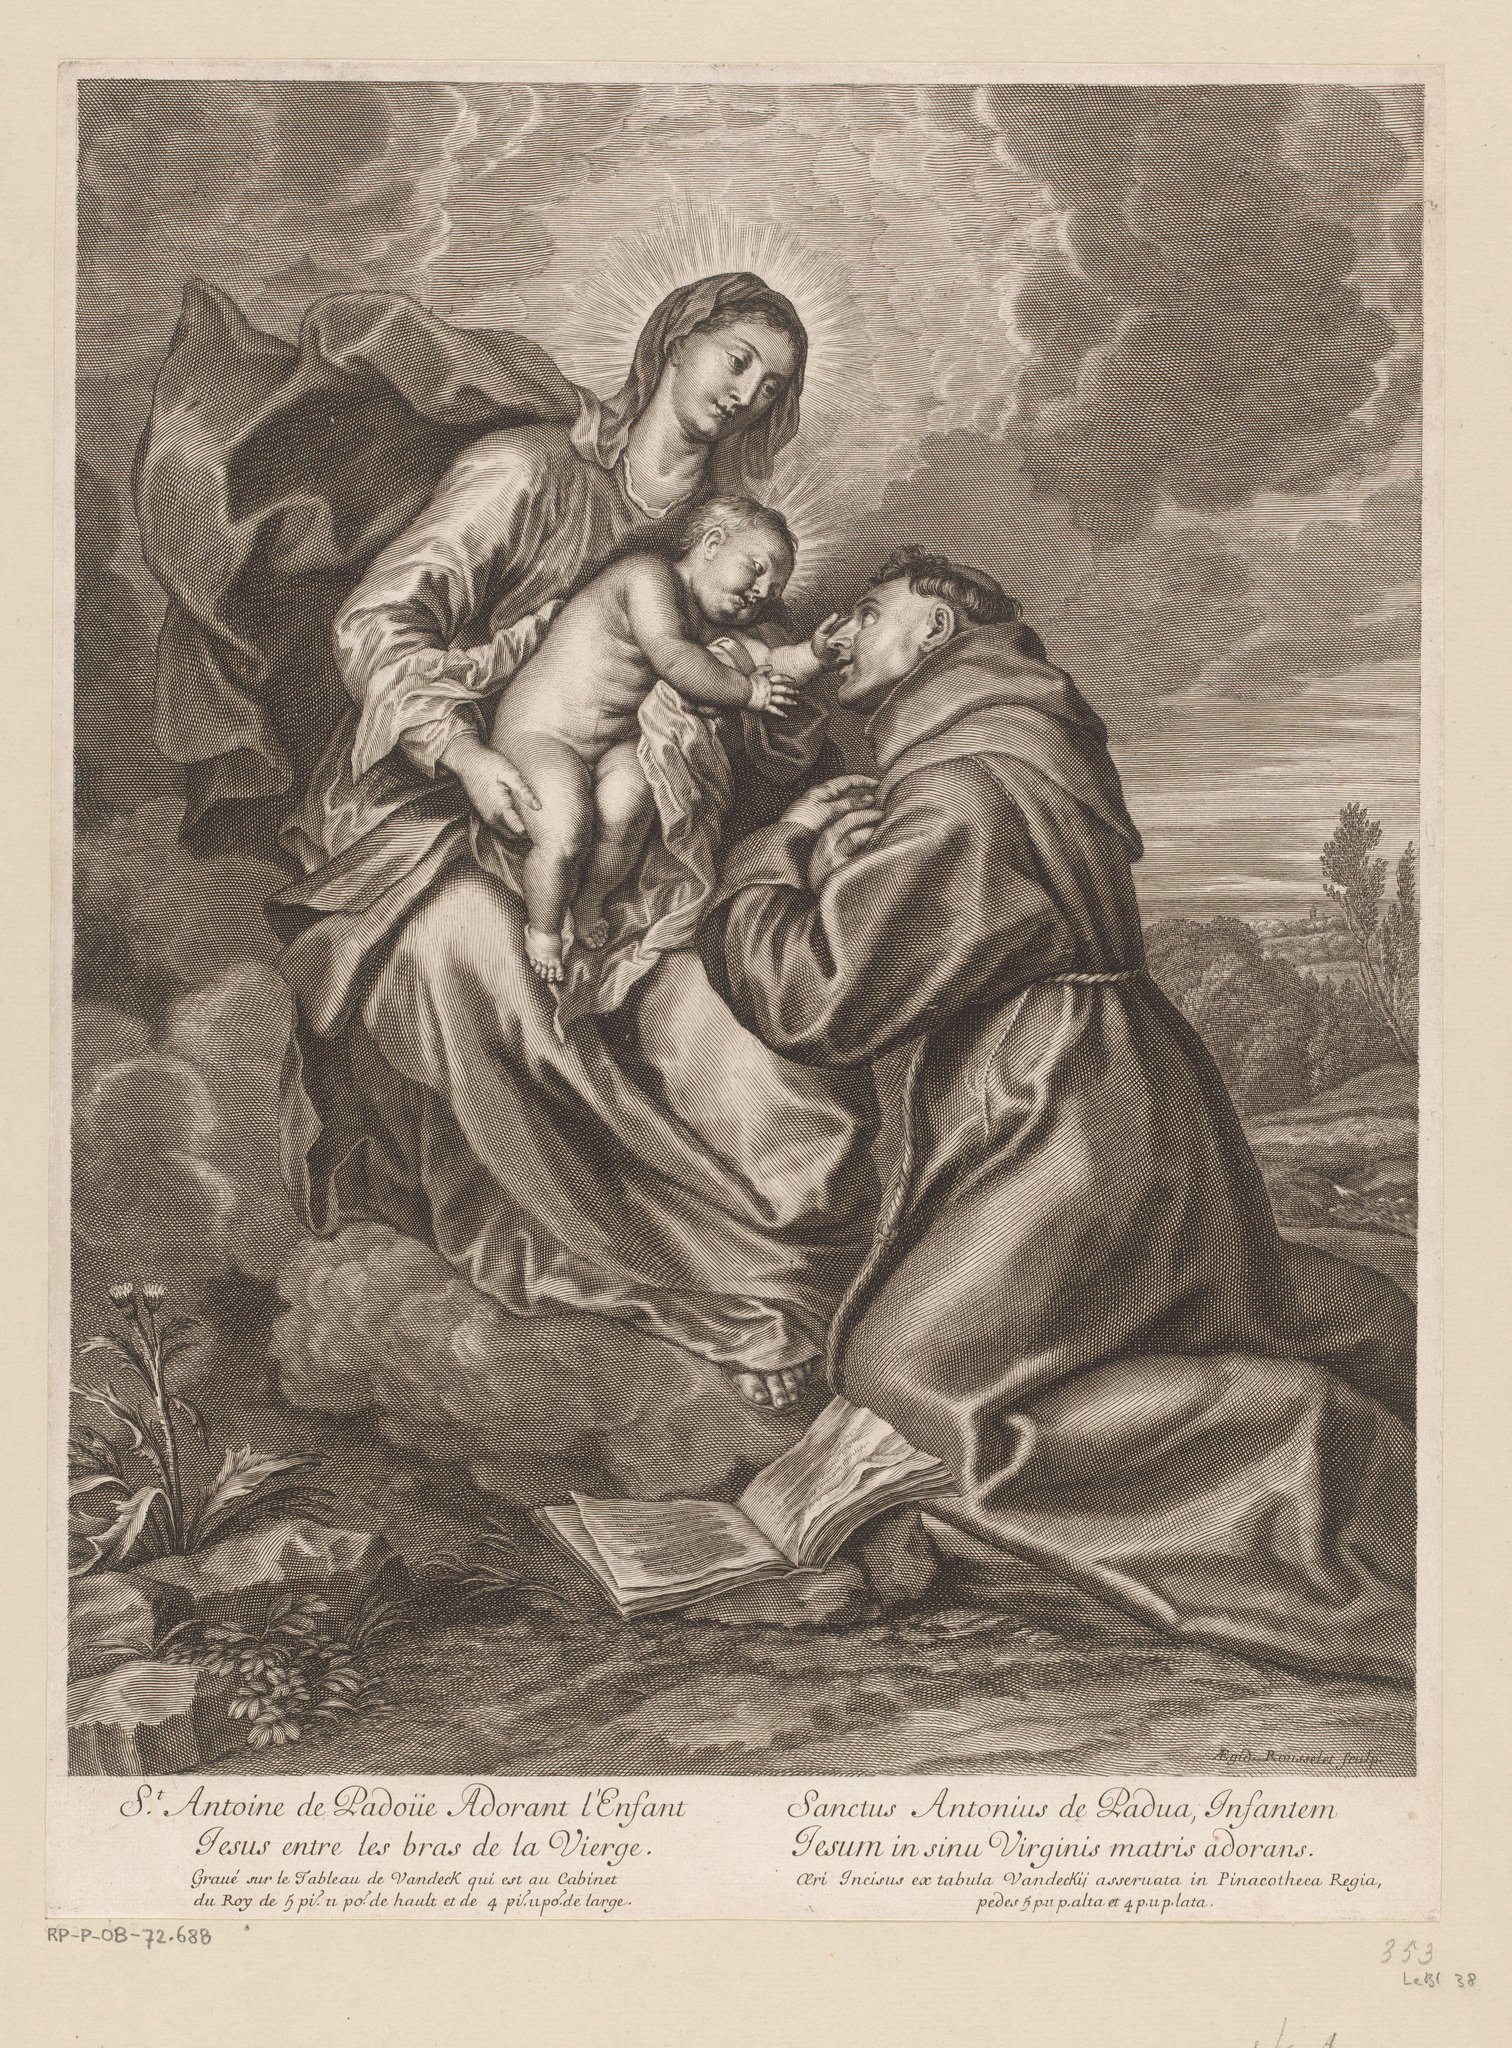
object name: print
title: Maria met kind en knielende Antonius van Padua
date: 1620-1686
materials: paper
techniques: engraving, etching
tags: visions of st. antony of padua, madonna: i.e. mary with the christ-child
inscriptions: collector's mark: Lugt 240